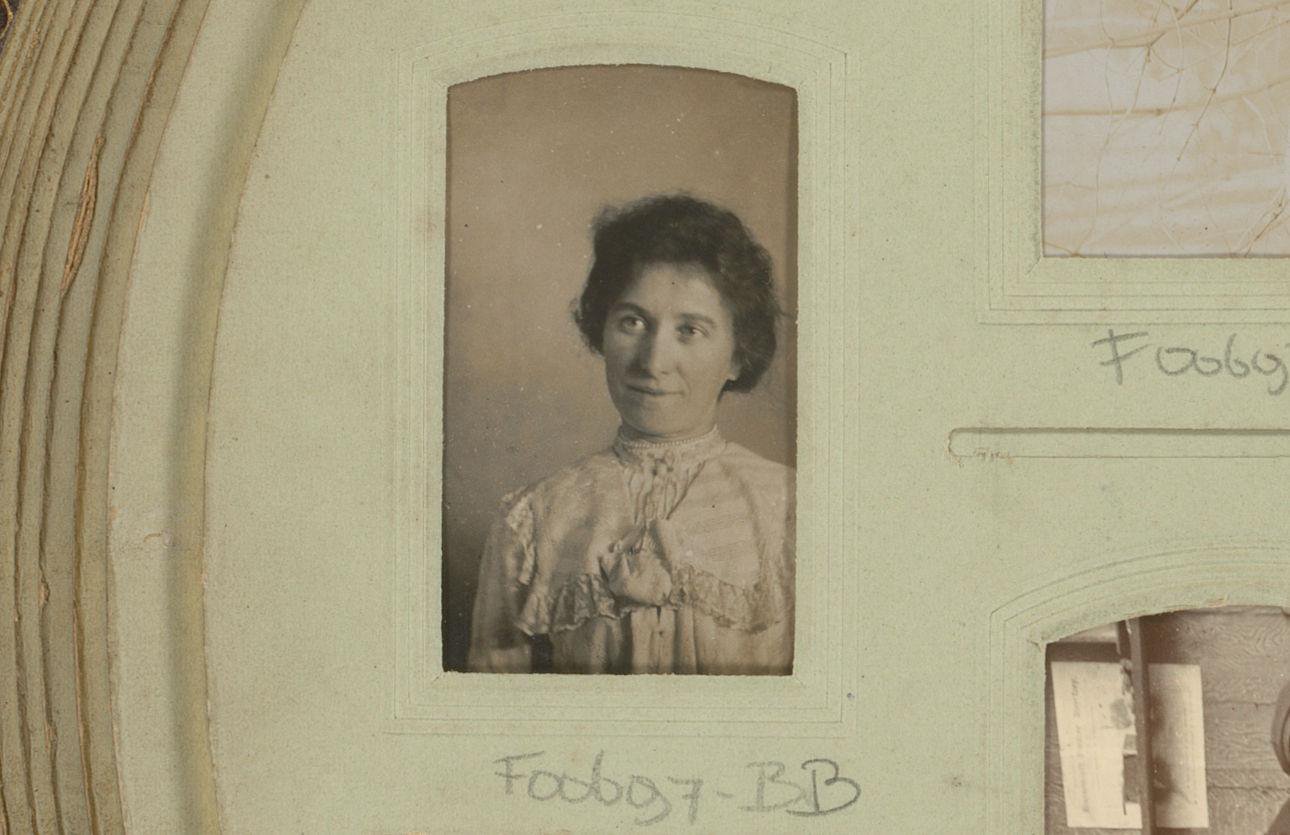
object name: album leaf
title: Portret van een vrouw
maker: Anonymous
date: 1890-1910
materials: photographic support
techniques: gelatin silver print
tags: adult woman, historical persons